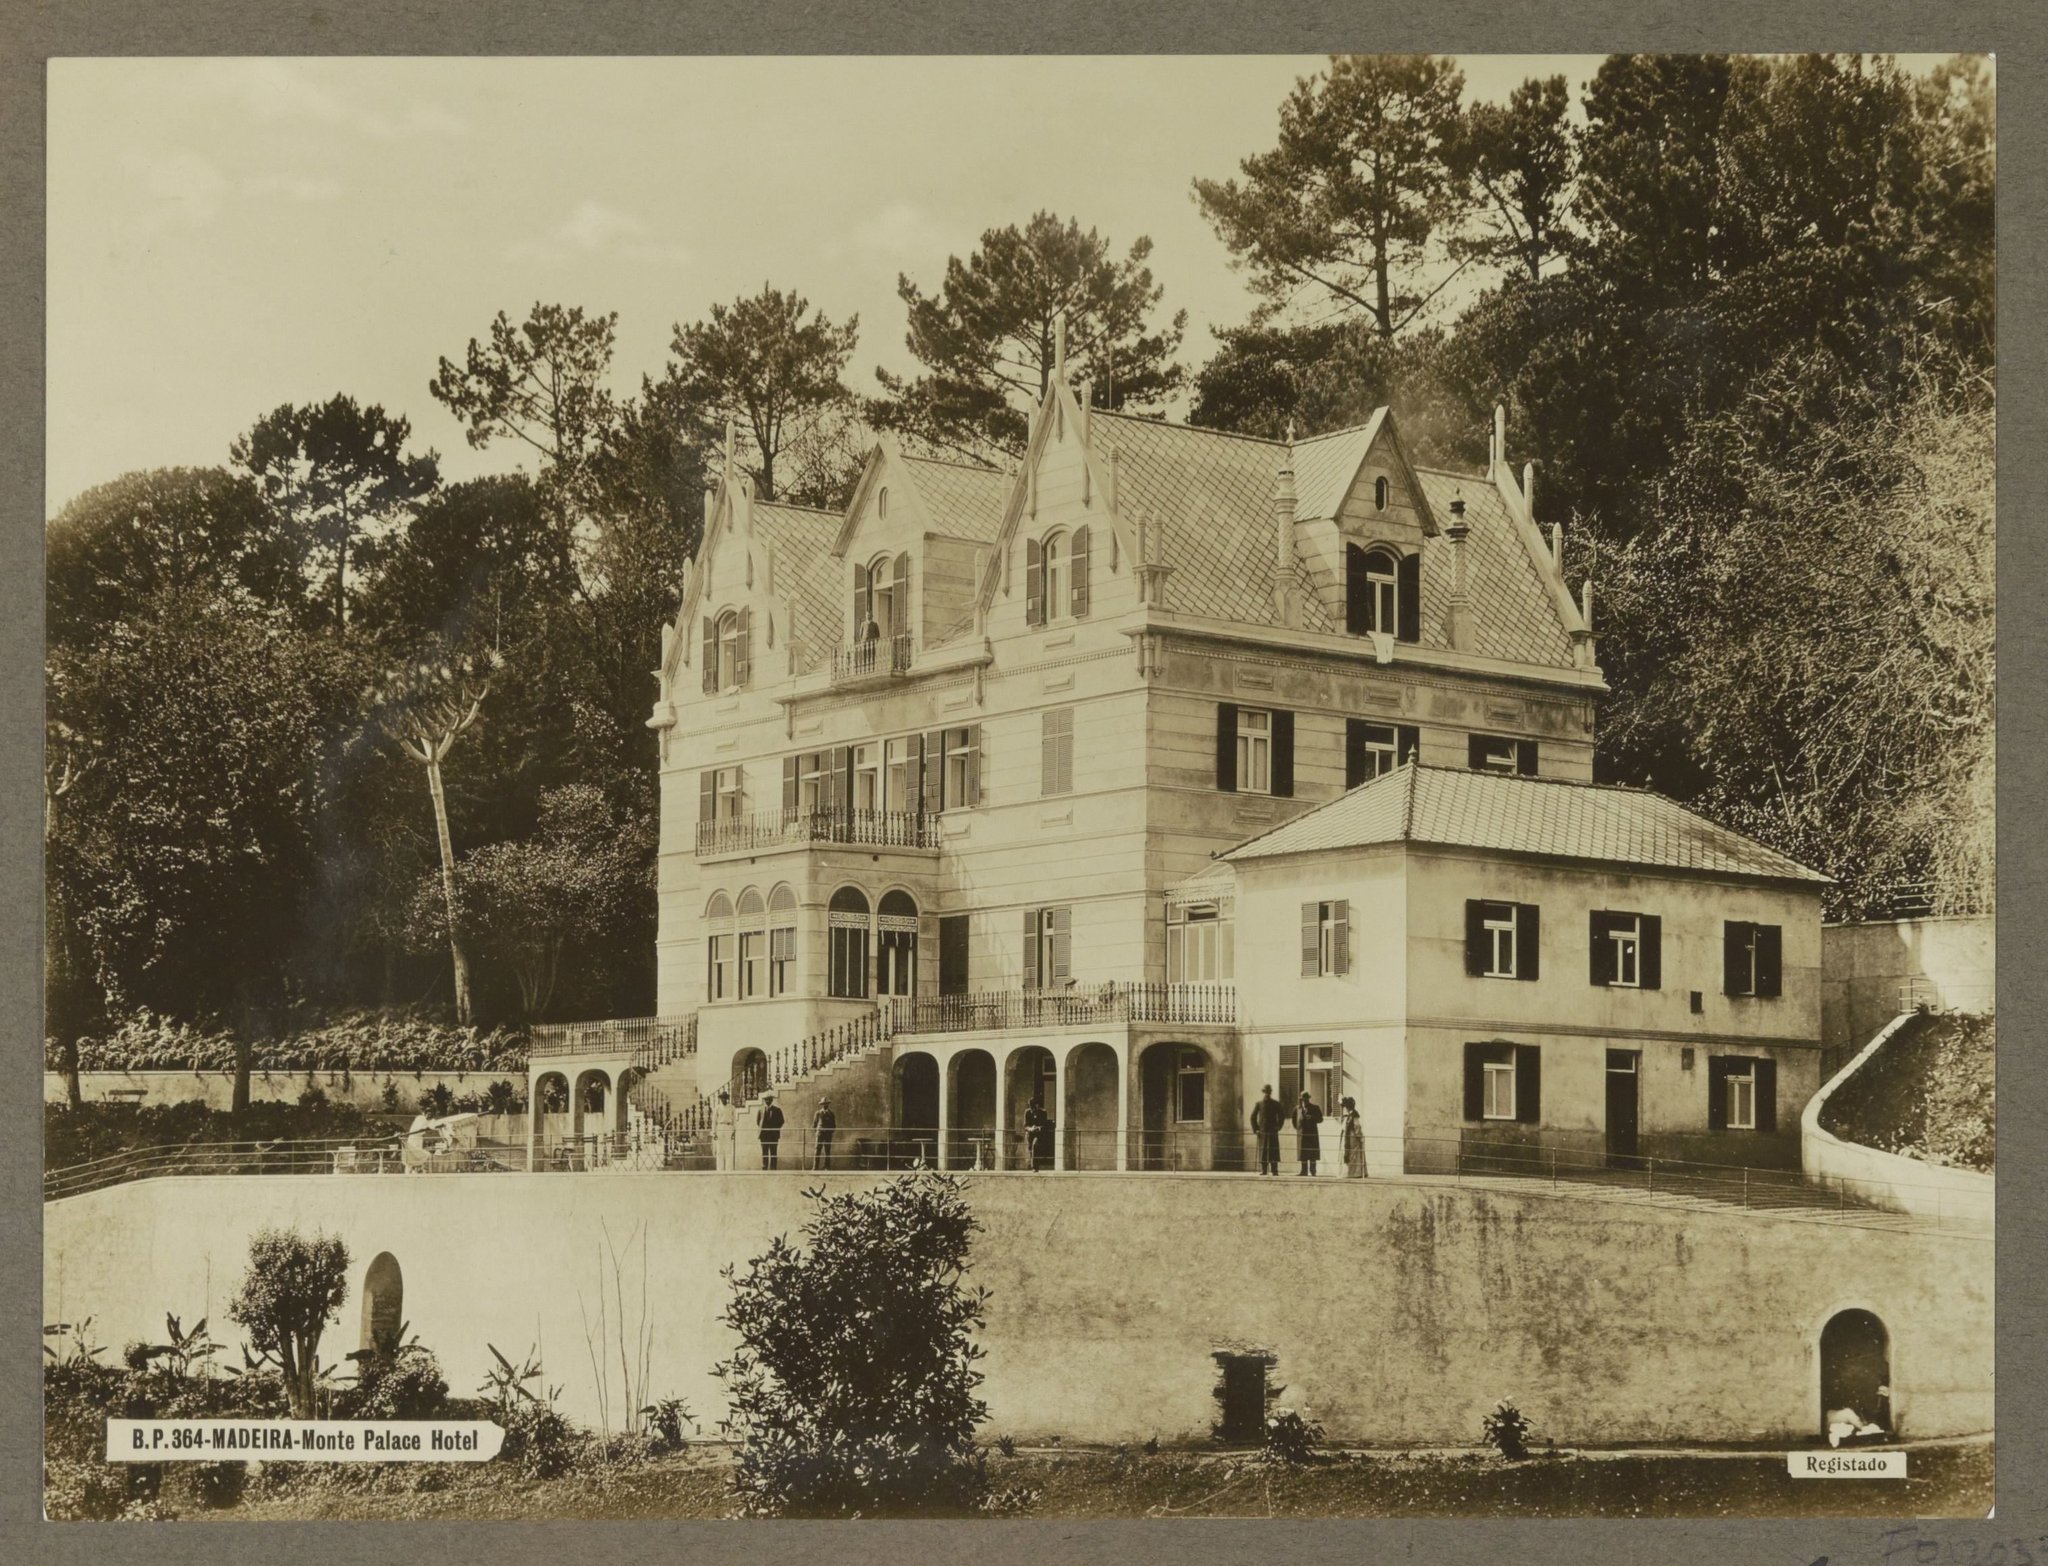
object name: photograph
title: Madeira-Monte Palace Hotel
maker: Anonymous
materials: photographic support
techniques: gelatin silver print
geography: madeira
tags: hotel, hostelry, inn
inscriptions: inscription: ‘Registado’, number: ‘B.P. 364’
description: Onderdeel van fotoalbum van een onbekende Nederlandse familie met opnames van Suriname, Europa en Nederlands-Indië.